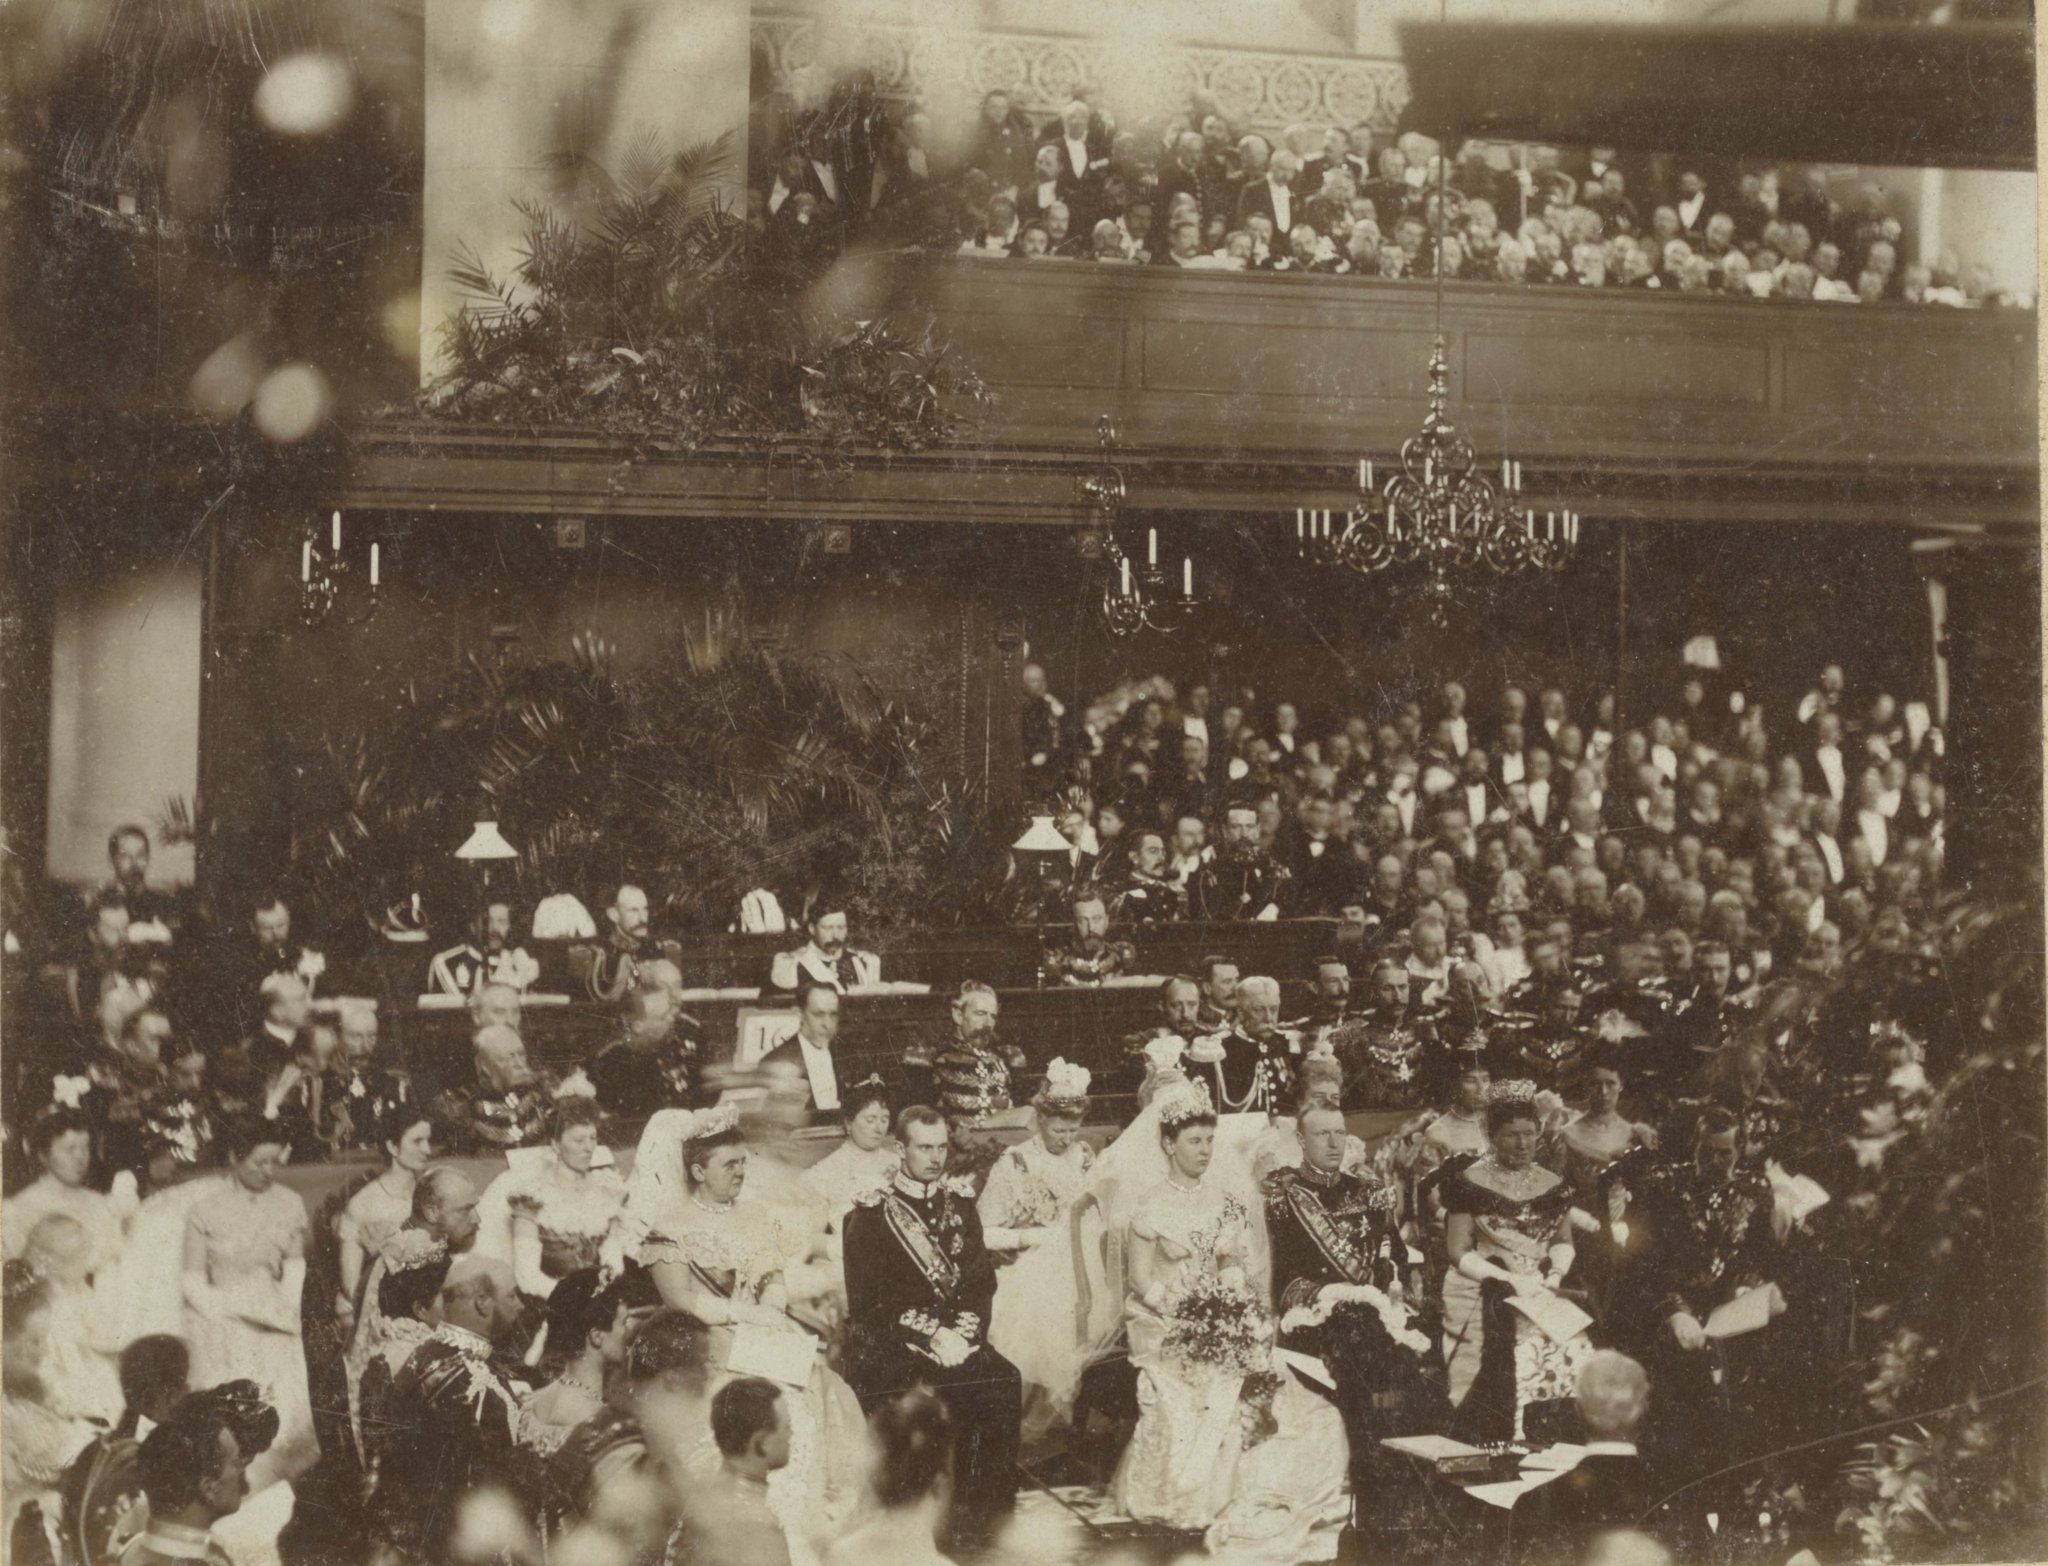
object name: photograph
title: Huwelijksvoltrekking tussen Koningin Wilhelmina en prins Hendrik in de Grote Kerk te Den Haag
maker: herman deutmann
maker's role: fotograaf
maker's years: 1870-1926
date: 1901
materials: cardboard, photographic support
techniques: albumen print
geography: the hague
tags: wilhelmina of the netherlands, hendrik (prins der nederlanden (1876-1934)), the hague, emma (queen consort of the netherlands)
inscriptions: inscription: ‘Huwelijk Wilhelmina Hendrik 7-2-1901 Nieuwe Kerk A'dam’, name: ‘H. Deutmann Art. Photographe 's Gravenhage Zeestraat 55’